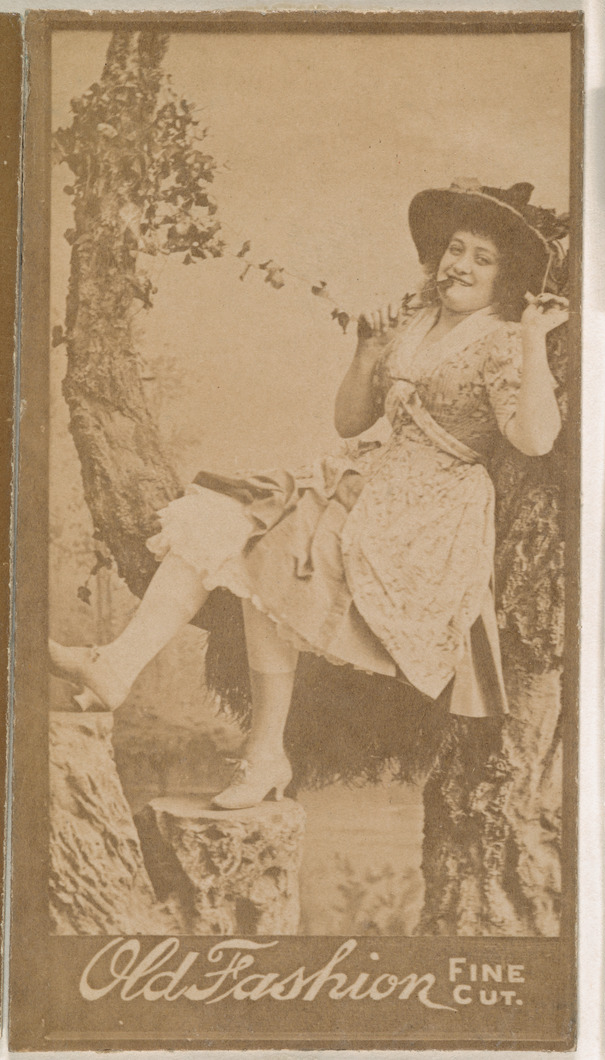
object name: photograph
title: Actress holding ivy vine, from the Actresses series (N664) promoting Old Fashion Fine Cut Tobacco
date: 1888-1890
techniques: albumen silver print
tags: portraits,women,actresses